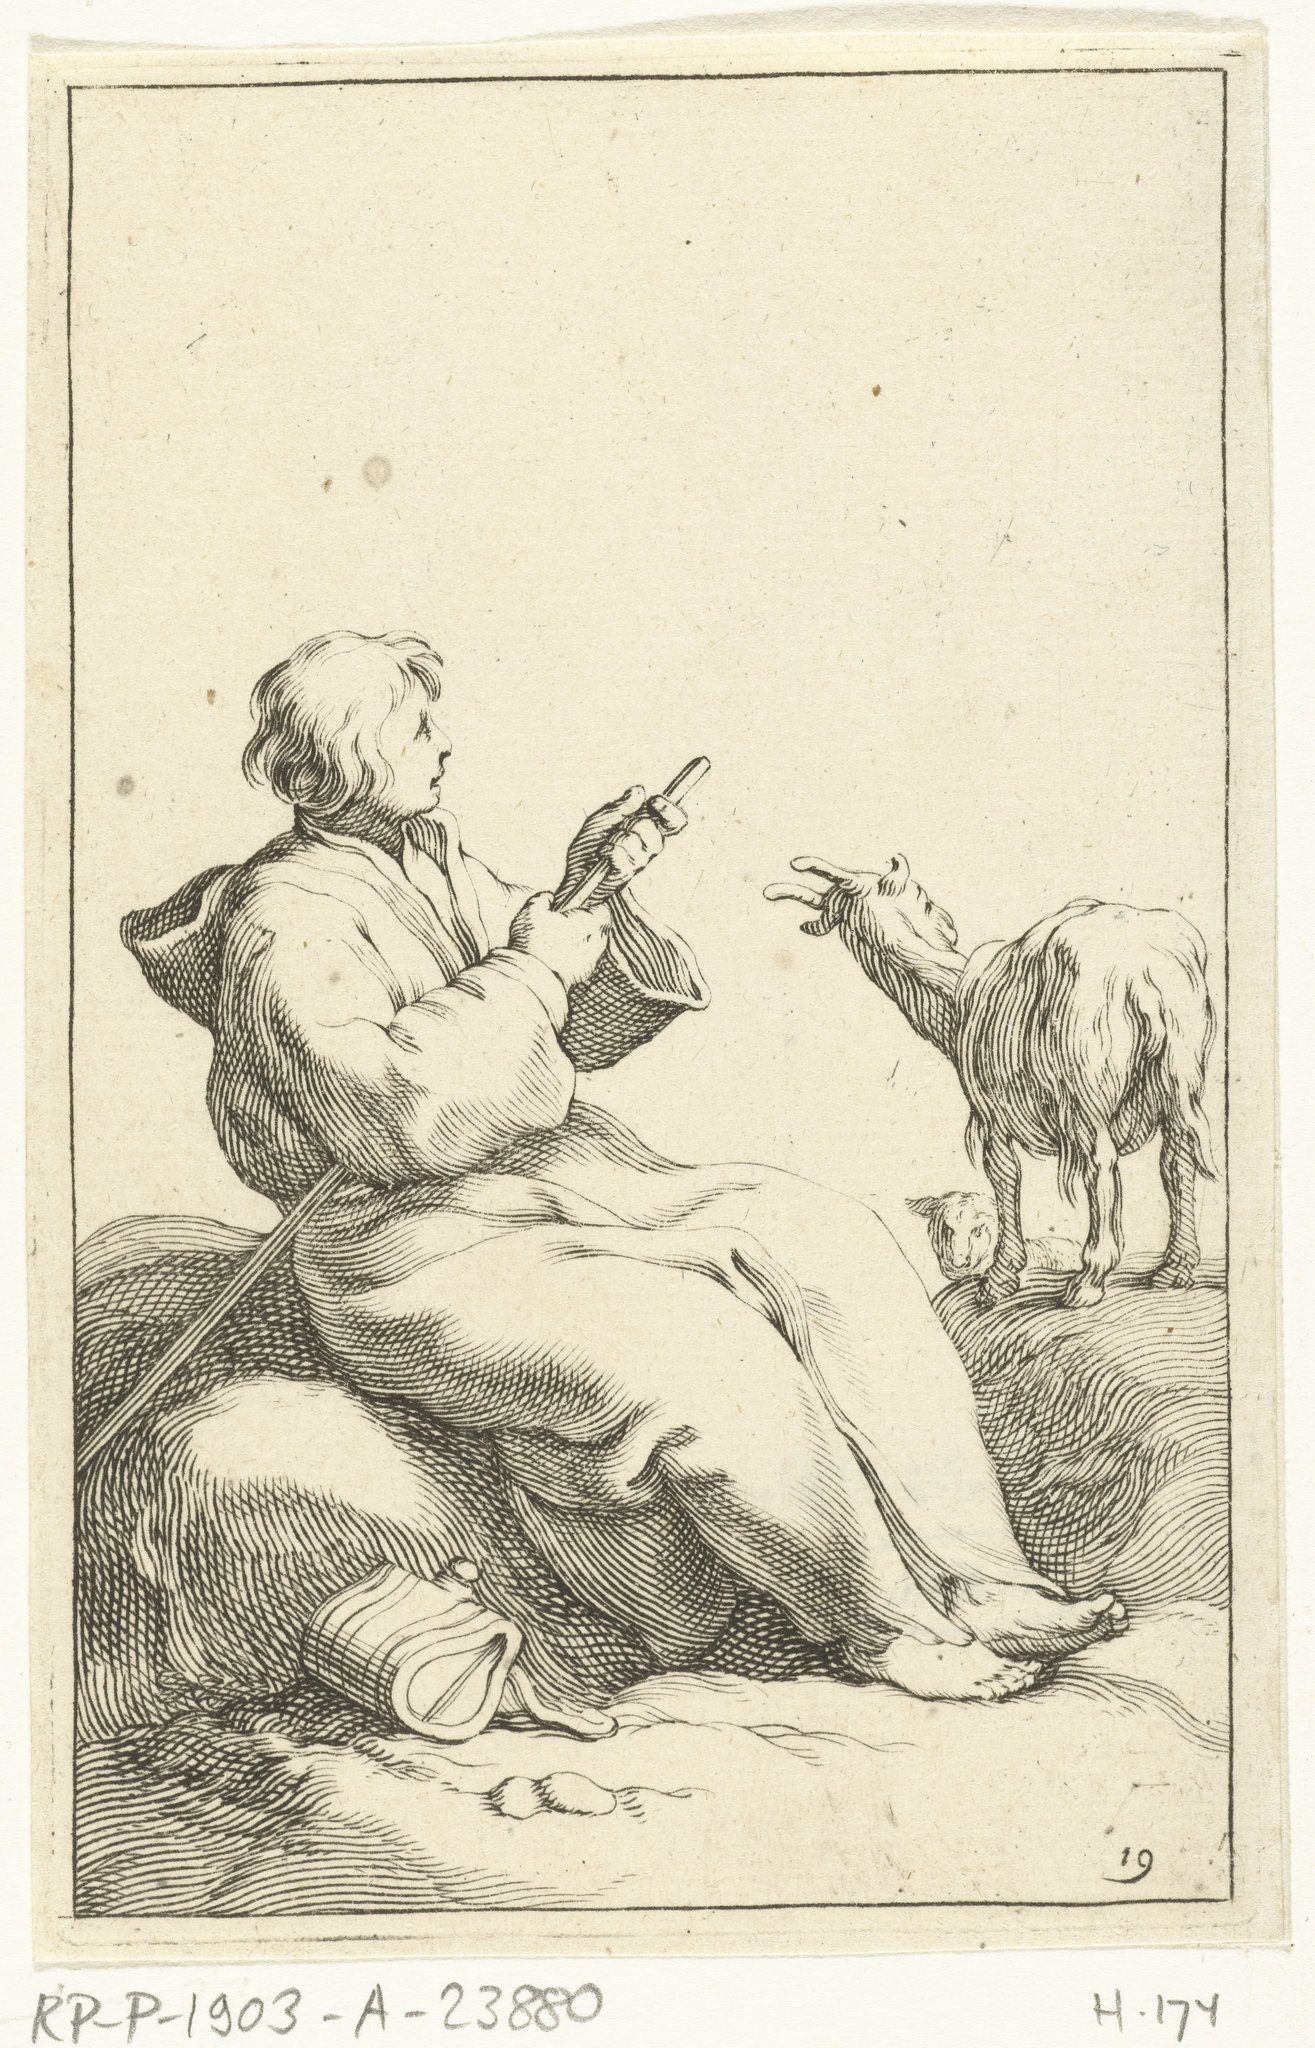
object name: print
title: De kleine figuren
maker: frederick bloemaert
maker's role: print maker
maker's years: 1614-1669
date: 1635-1669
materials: paper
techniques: engraving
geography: utrecht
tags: herding, herdsman, herdswoman, shepherd, shepherdess, cowherd, etc.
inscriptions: collector's mark: Lugt 2228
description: Een zittende man met een stok in zijn handen. Op de grond een tas. Naast hem twee geiten.